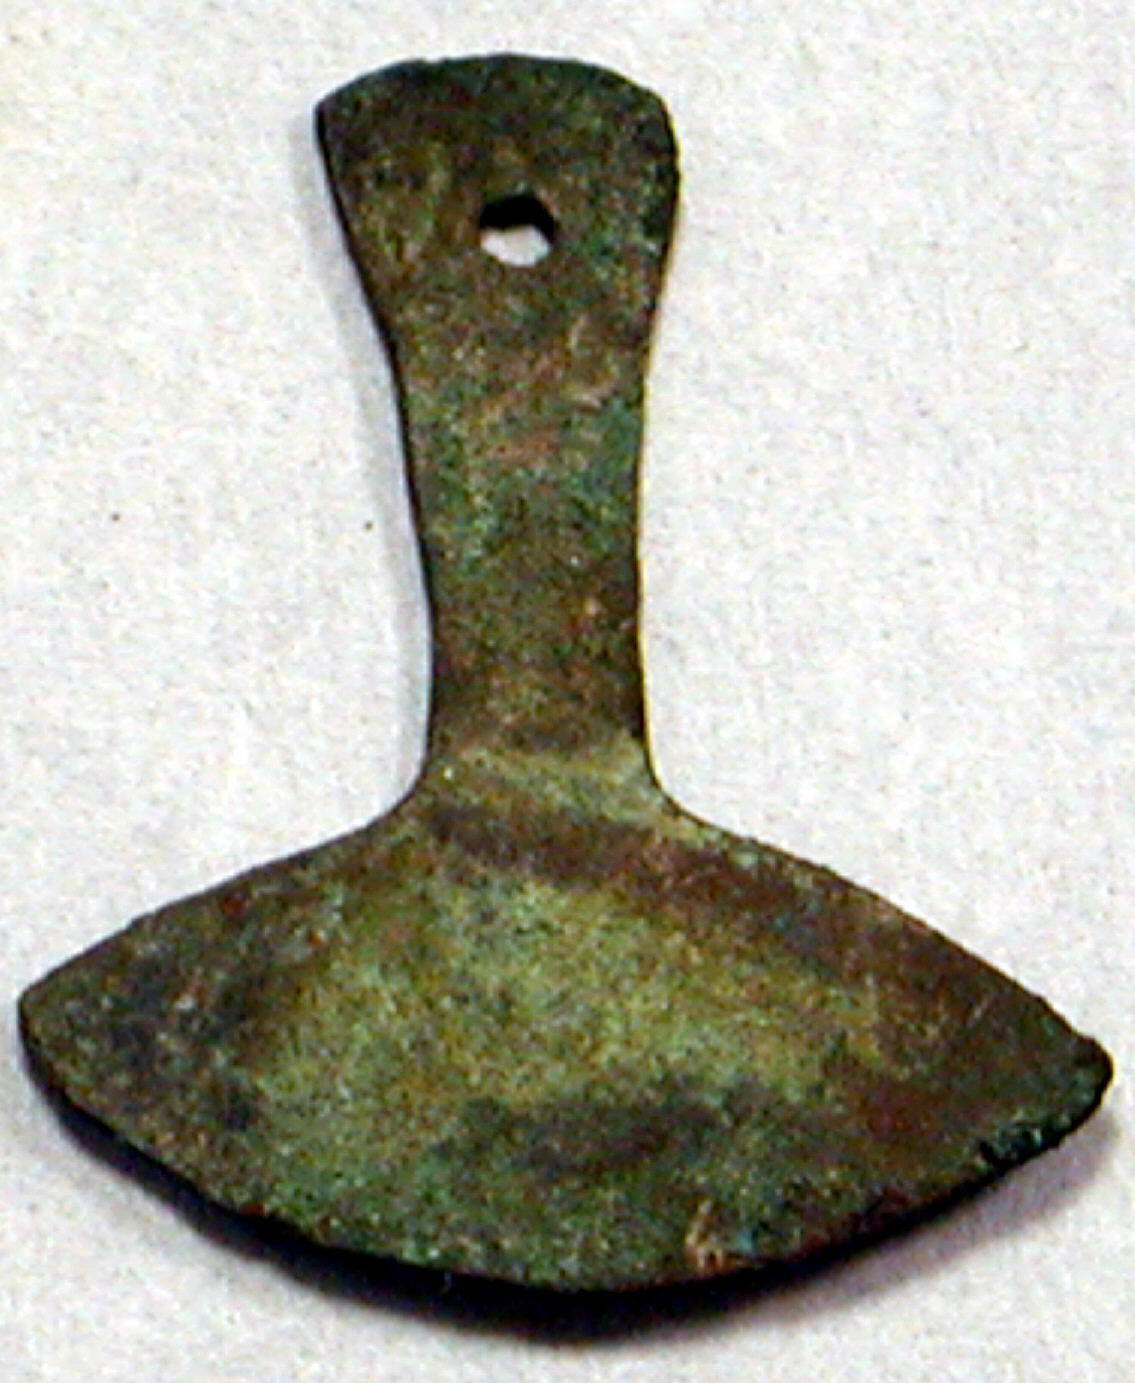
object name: miniature knife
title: Copper Tumi Pendant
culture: peruvian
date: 1401-1500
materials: copper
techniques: hammering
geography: peru